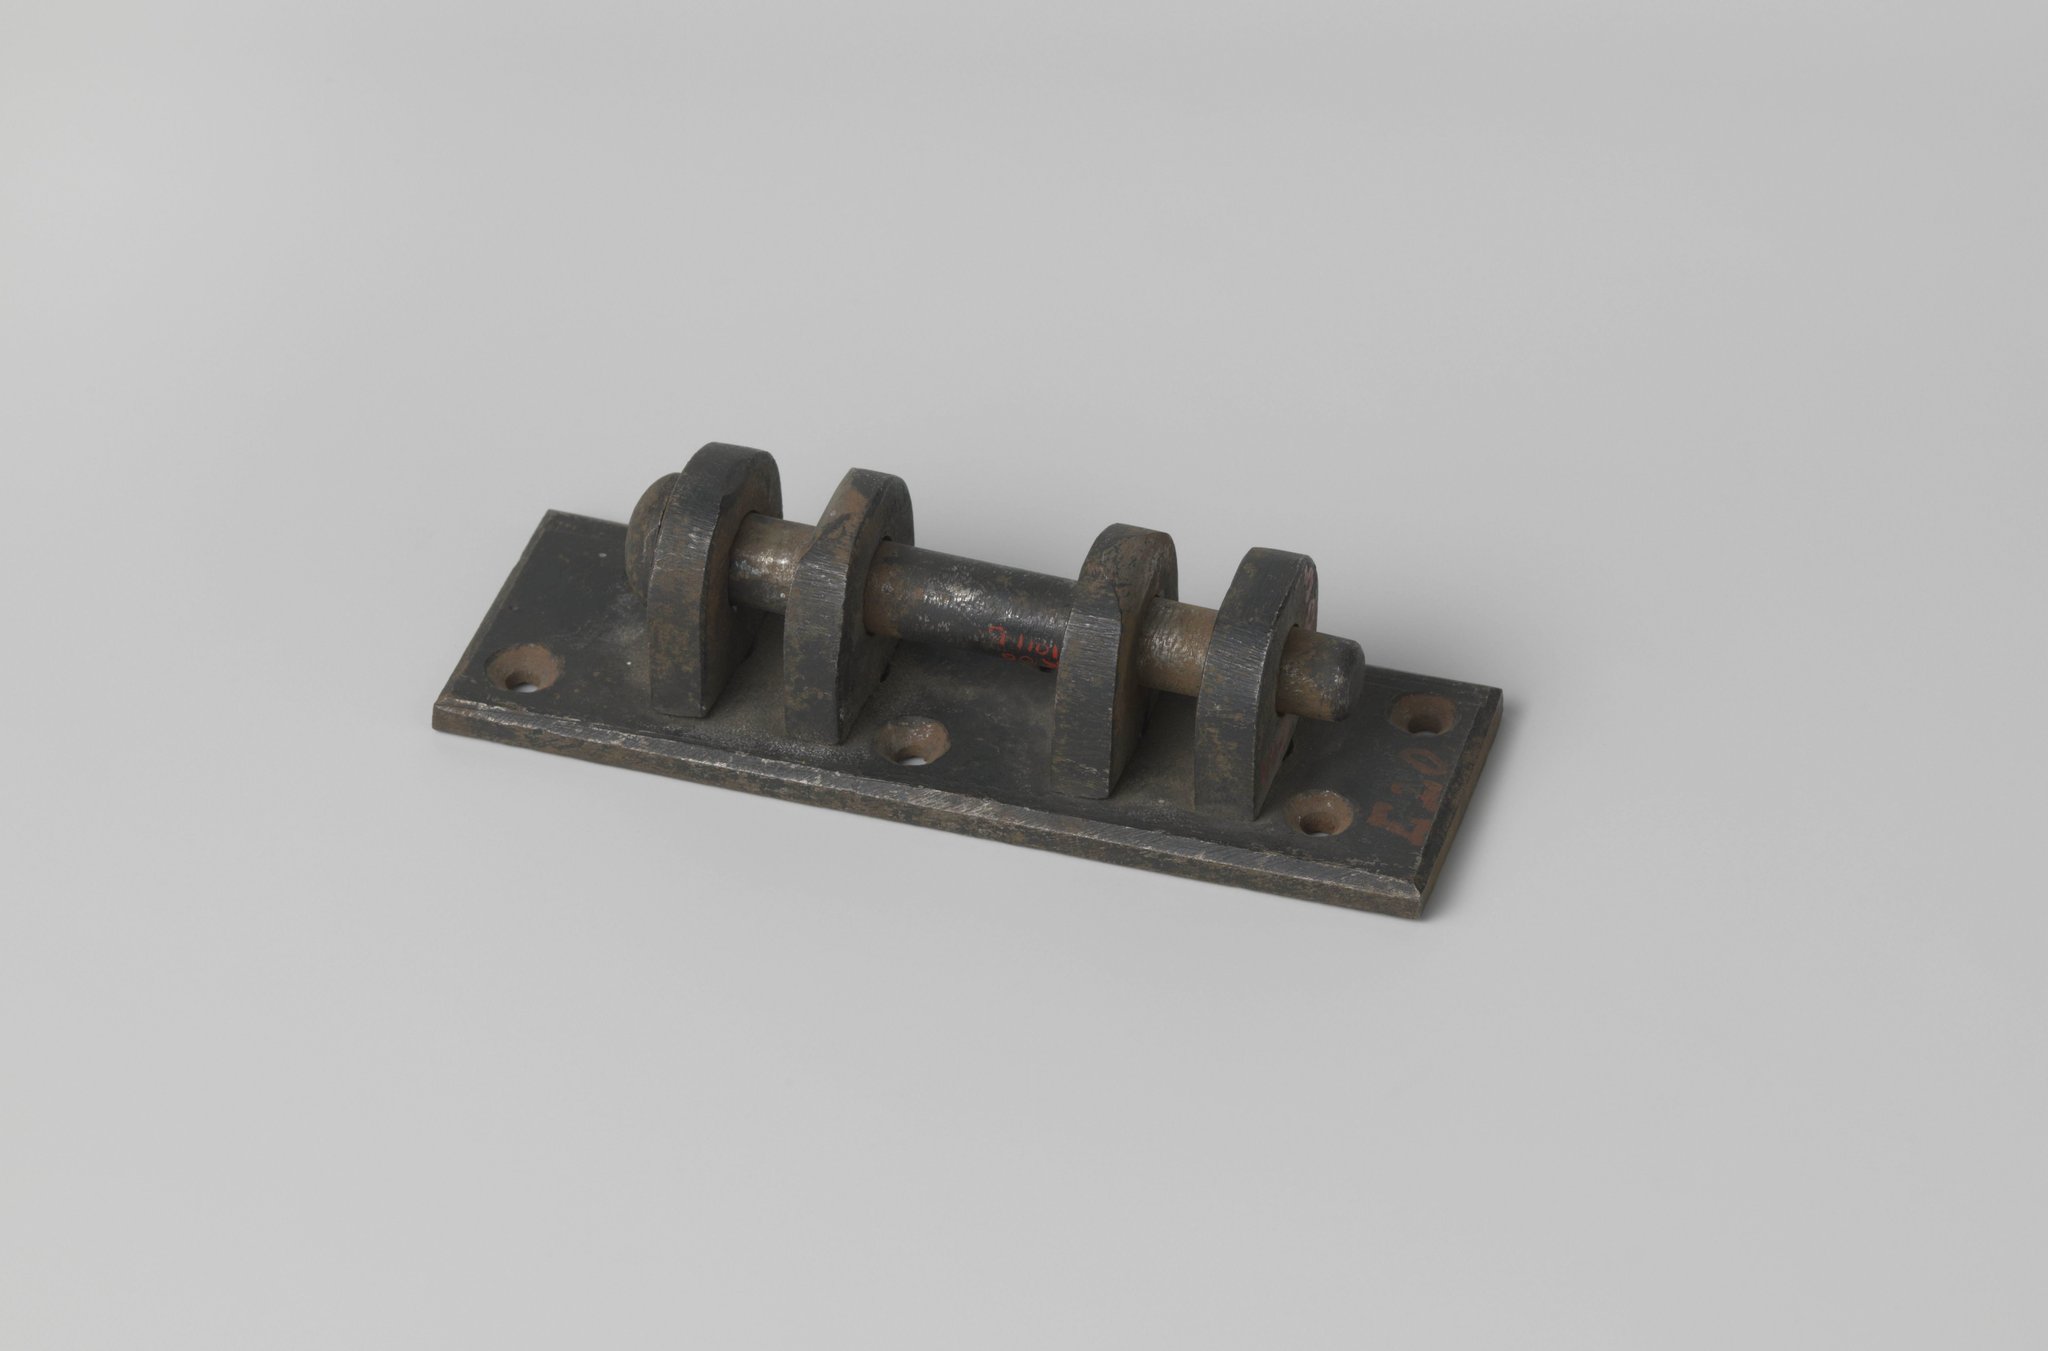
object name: chandelier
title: Arm met kaarsenhouder, onderdeel van een kaarsenkroon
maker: Anonymous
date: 1650-1725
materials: brass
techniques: casting, screwed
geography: netherlands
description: Het voorwerp is samengesteld uit de volgende vijf onderdelen: de arm, de vetvanger, de draaier, de kaarsenhouder. De arm is tweemaal gebogen, aan één kant eindigend in een spiraal met vogel- of dolfijnenkop, op het andere eind in een verdikking. Hierin is de draaier op de aan de onderkant geprofileerde ronde vetvanger geschroefd. Op de draaier zijn twee cylindrische kaarsenhouders met cylindrische stammen geschroefd. De arm is juist onder de verdikking afgebroken, en de verbindingskrul is hersteld. Bovendien wijken de vetvanger en één der houders iets af van die van BK-KOG-1011-A. Het voorwerp is met een ijzeren pin bevestigd in de ogen van een ijzeren onderdeel, dat aan de een muur geschoefd kan worden. De kaarsenhouder en vetvanger zijn oorspronkelijk onderdeel van een kaarsenkroon geweest. De baluster, waarop de arm oorspronkelijk was gestoken, alsmede de knoppen ontbreekt.